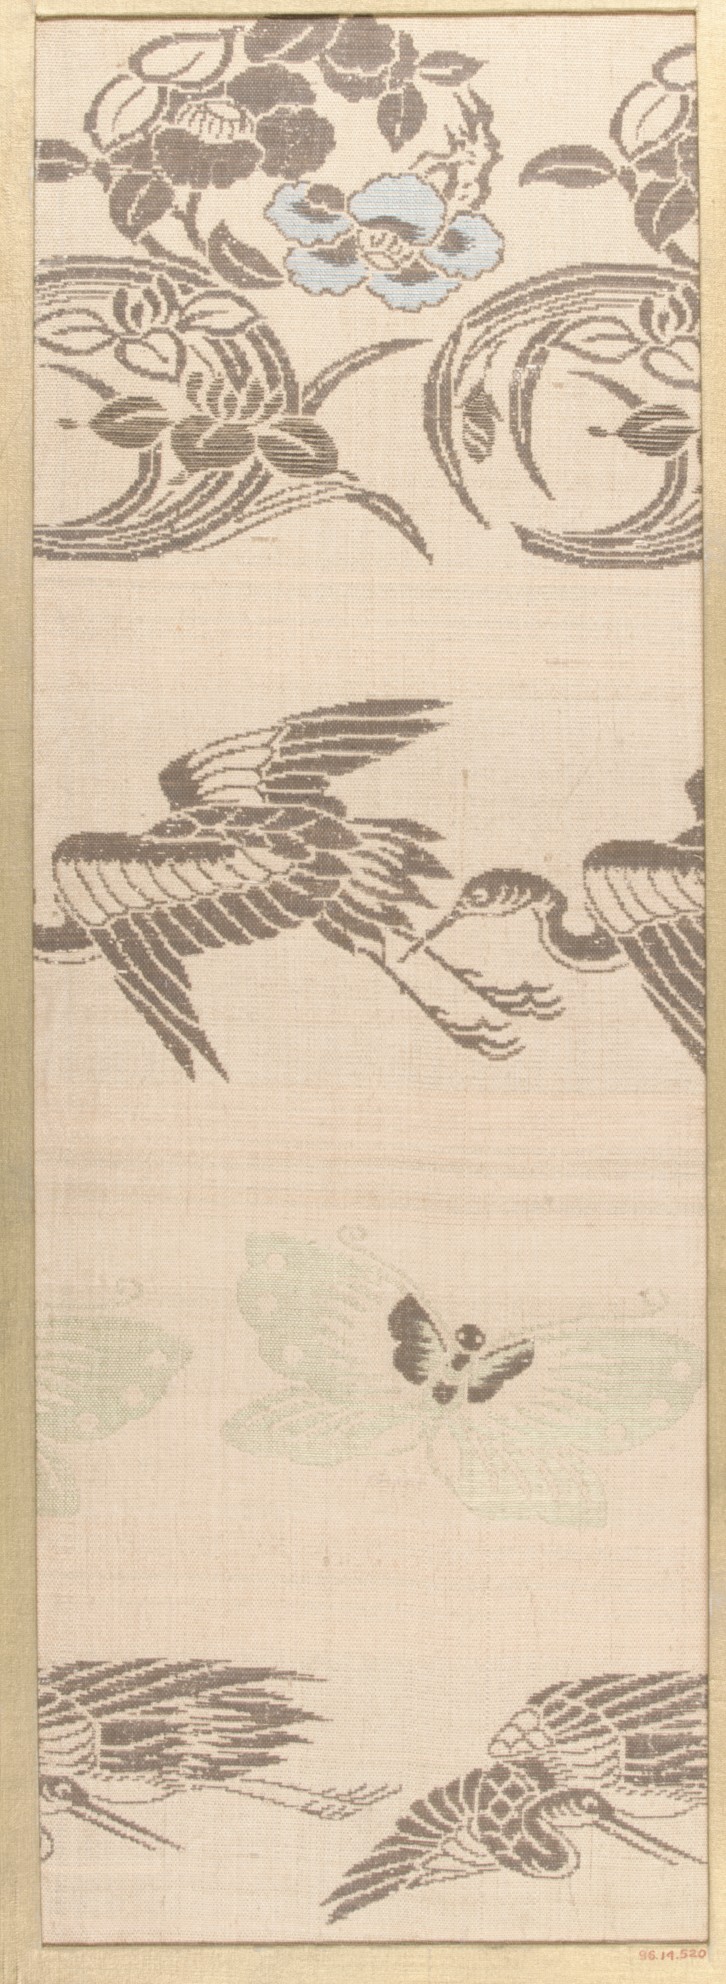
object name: piece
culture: japanese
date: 1701-1900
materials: silk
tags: butterflies,flowers